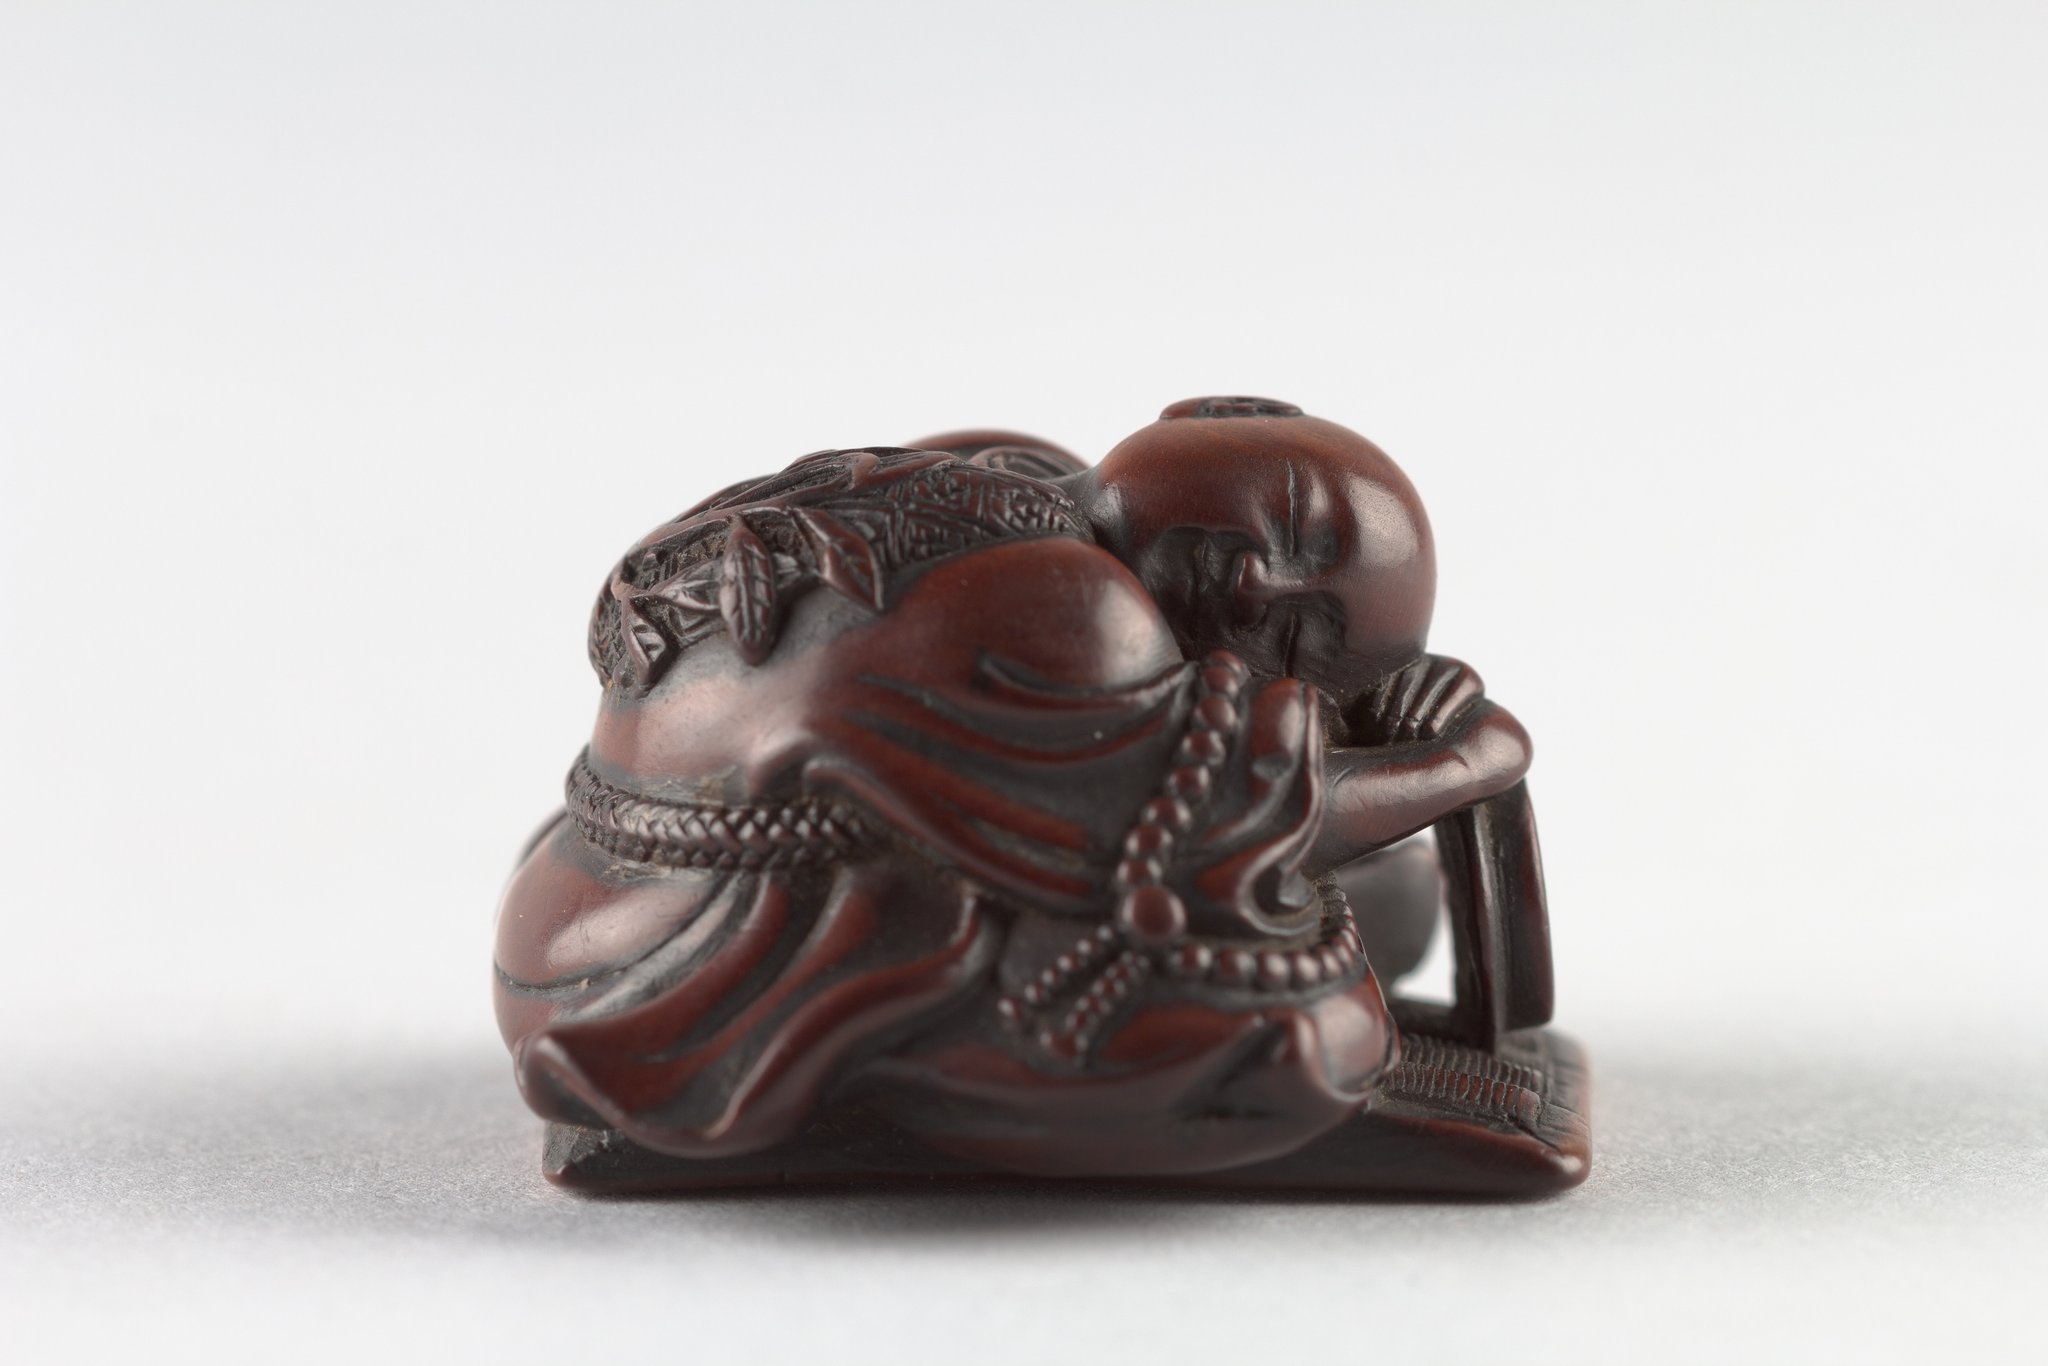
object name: netsuke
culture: japanese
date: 1801-1900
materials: wood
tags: men